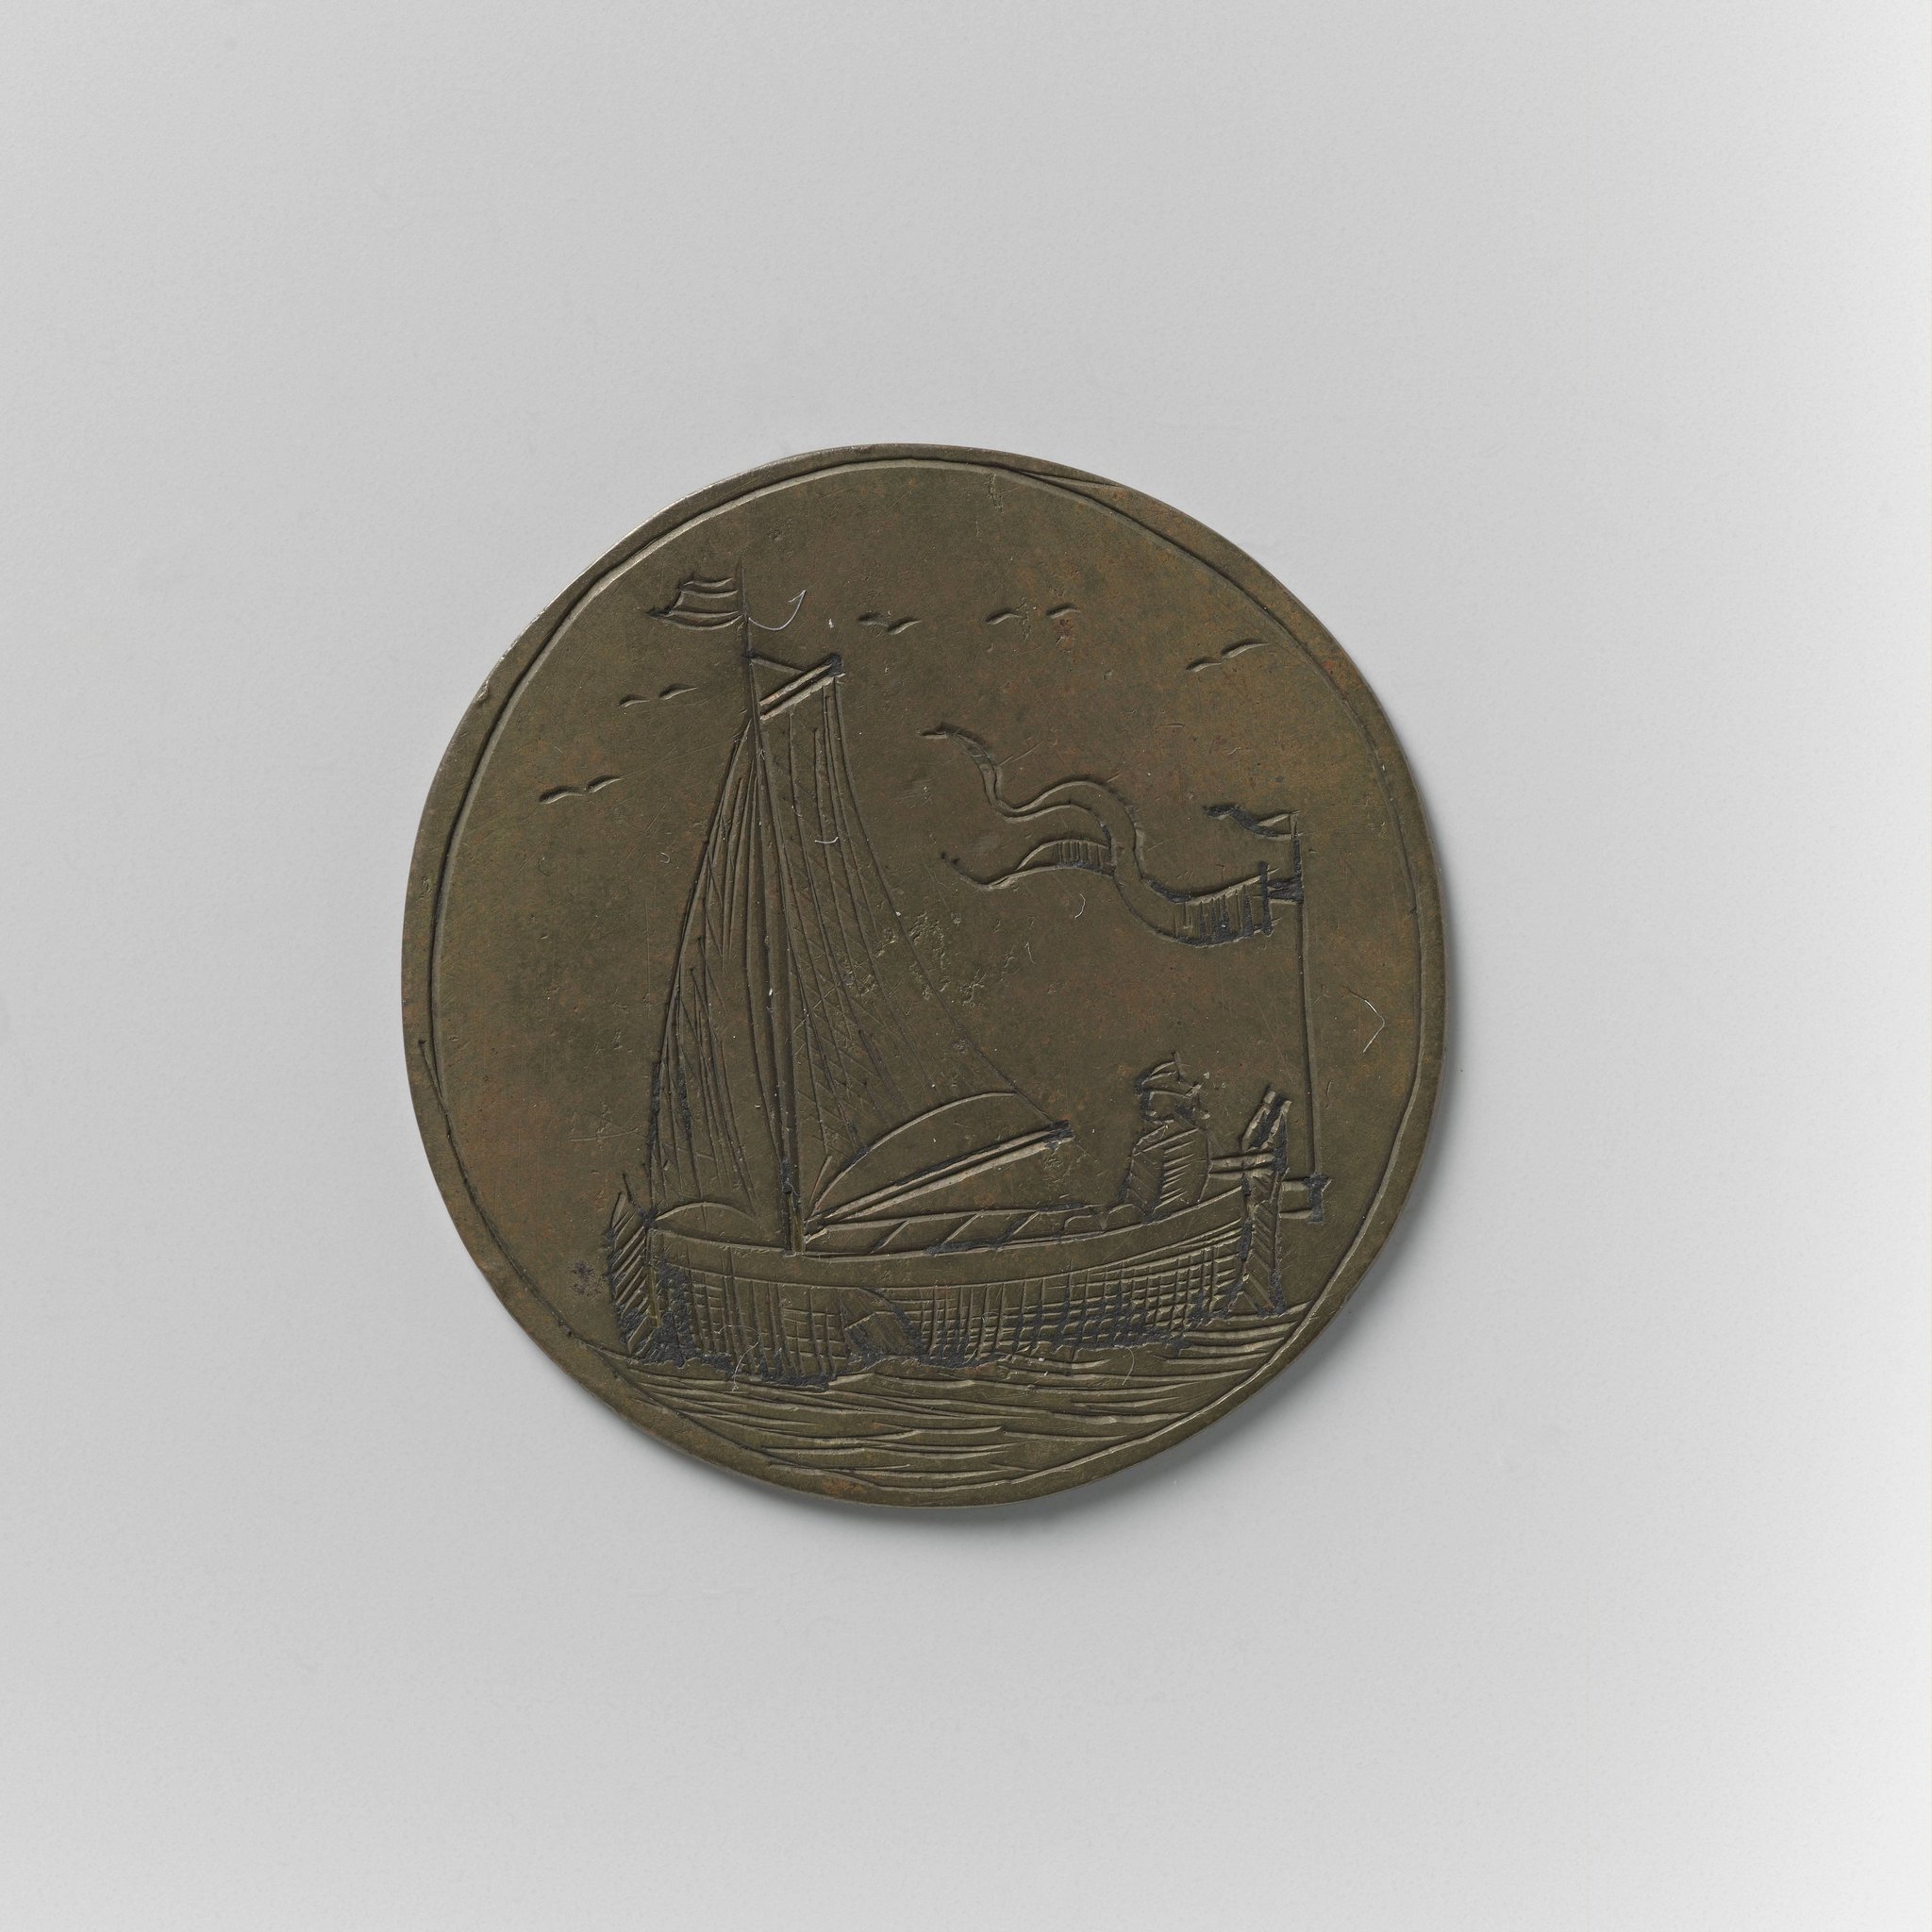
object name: medal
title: Roei-, steiger- en schuitenvoerdersgilde van Amsterdam, gildepenning van Johannes Blat, ligplaats Kamper steiger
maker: Anonymous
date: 1776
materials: brass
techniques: engraving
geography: amsterdam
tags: amsterdam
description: Messing penning. Voorzijde: naar links varende zeilboot; op achterplecht: zittende man en vlag. Keerzijde: opschrift boven huismerk en hart met daarin letters I en B tussen monogram van letters K en S